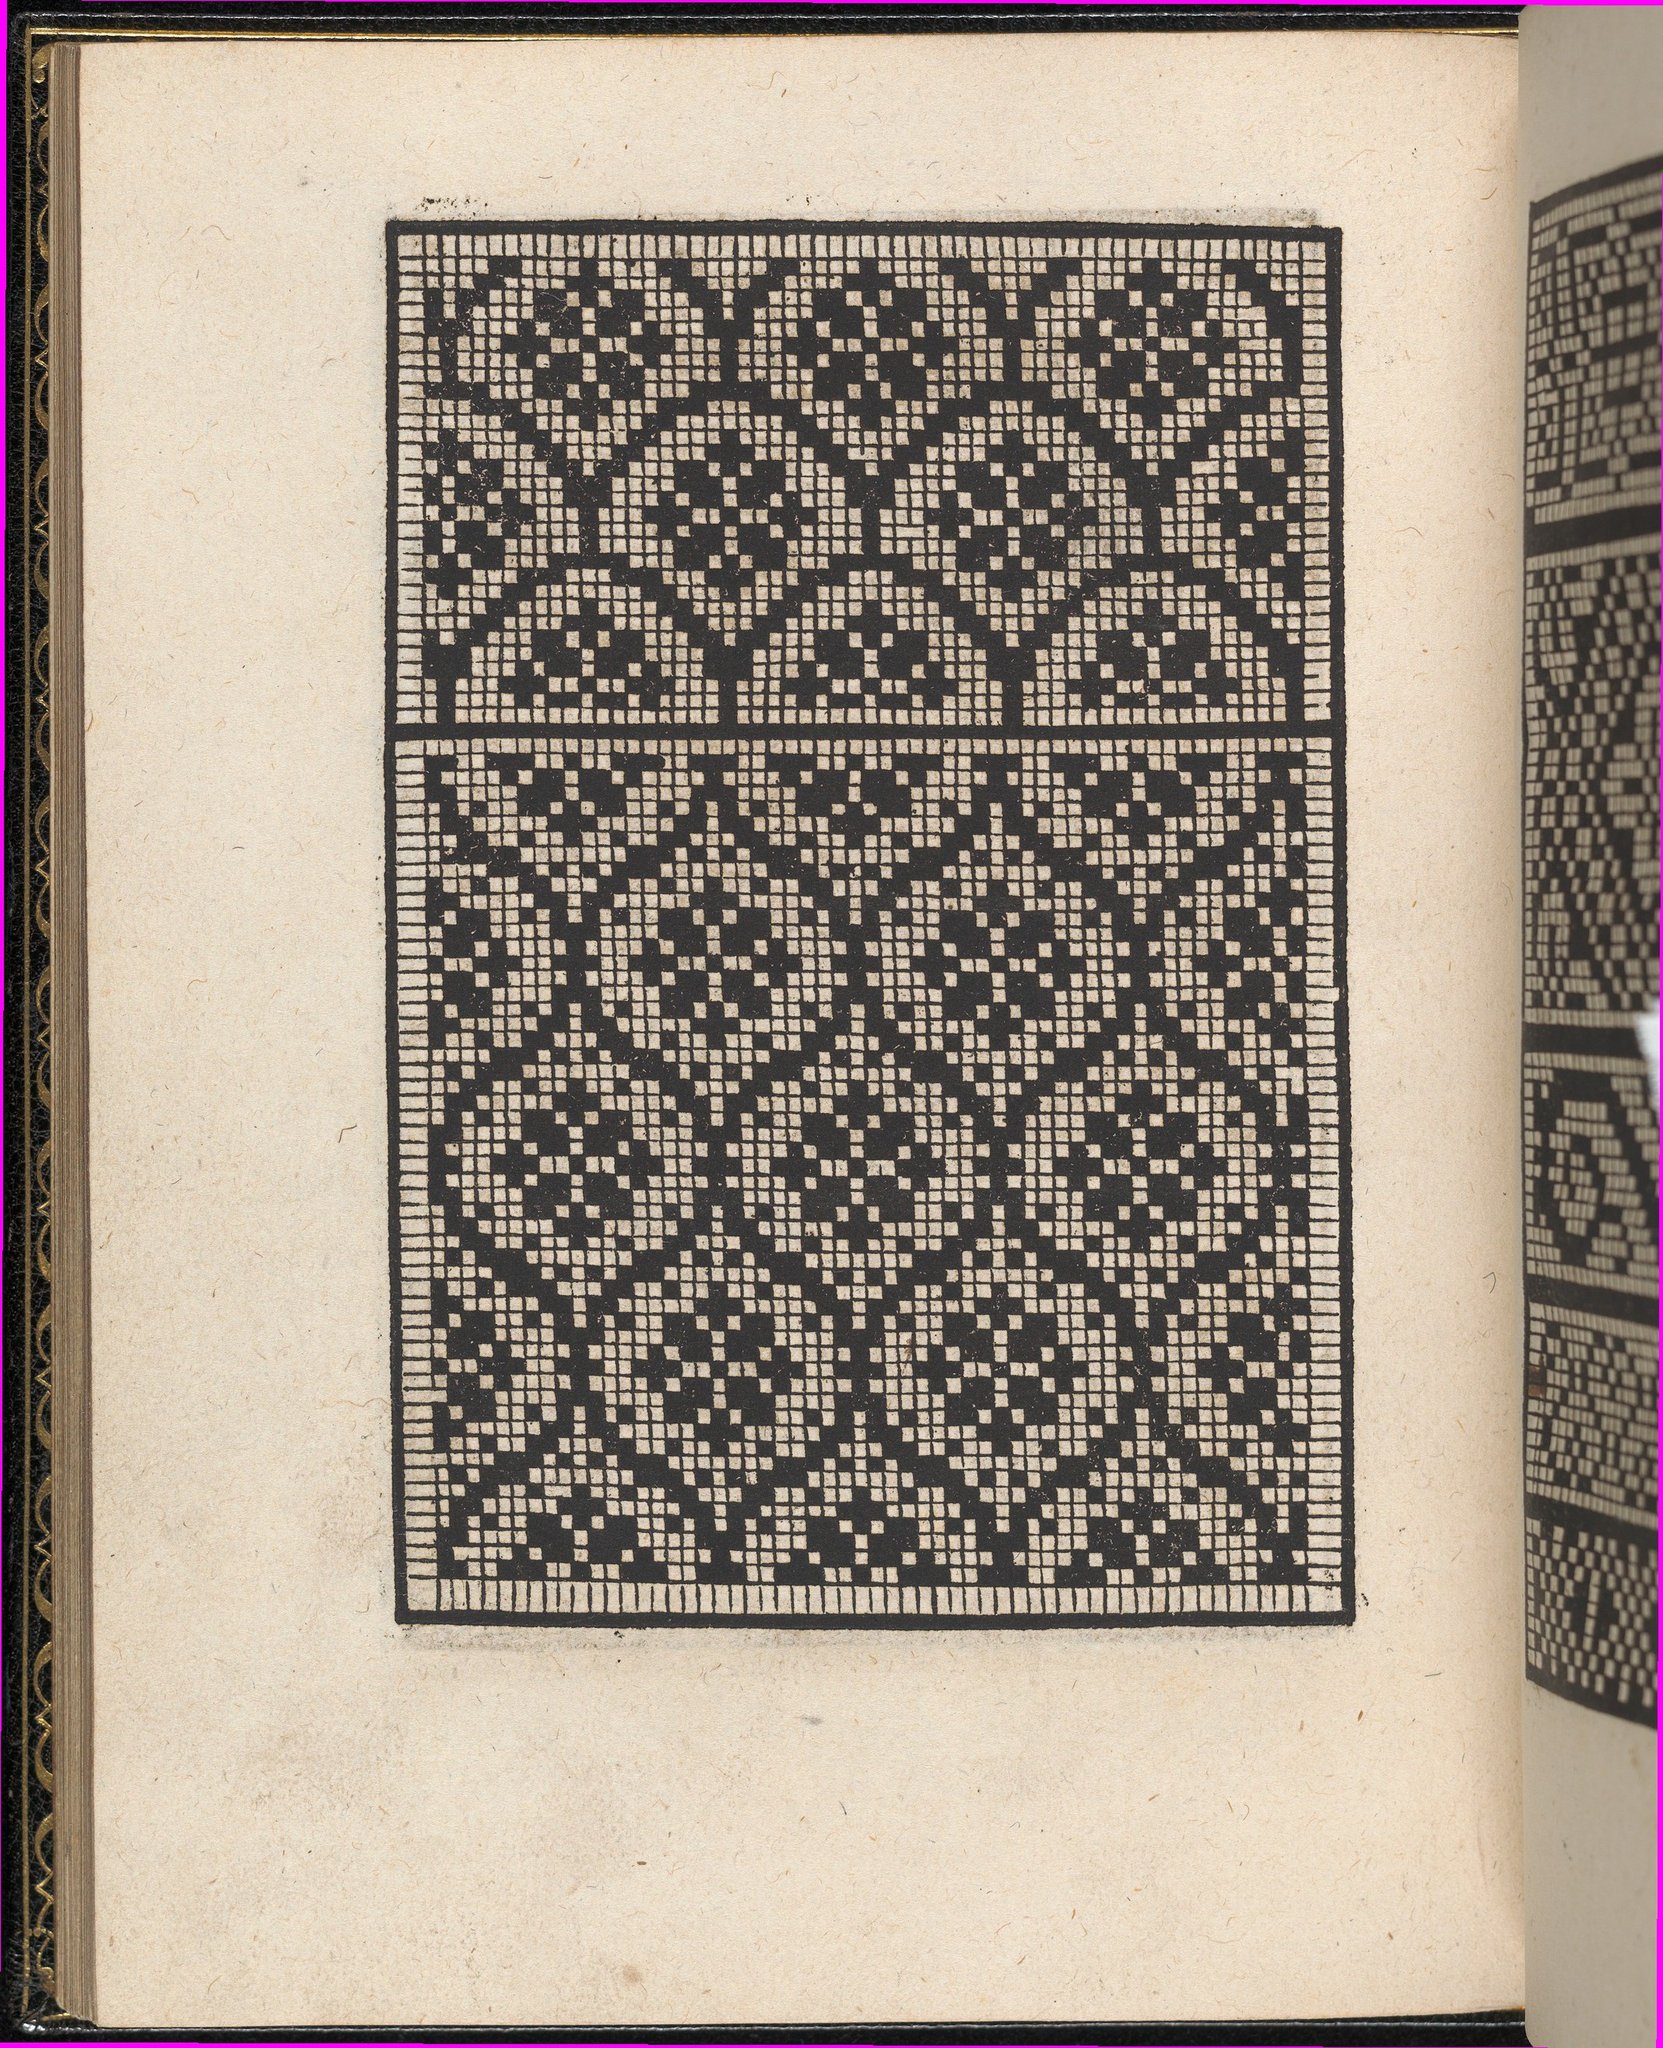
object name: book print ornament architecture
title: Page from Ein new kunstlich Modelbuch...(Page 38v)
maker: peter quentel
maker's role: publisher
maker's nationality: german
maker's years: 1500-1550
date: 1544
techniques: woodcut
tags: ornament